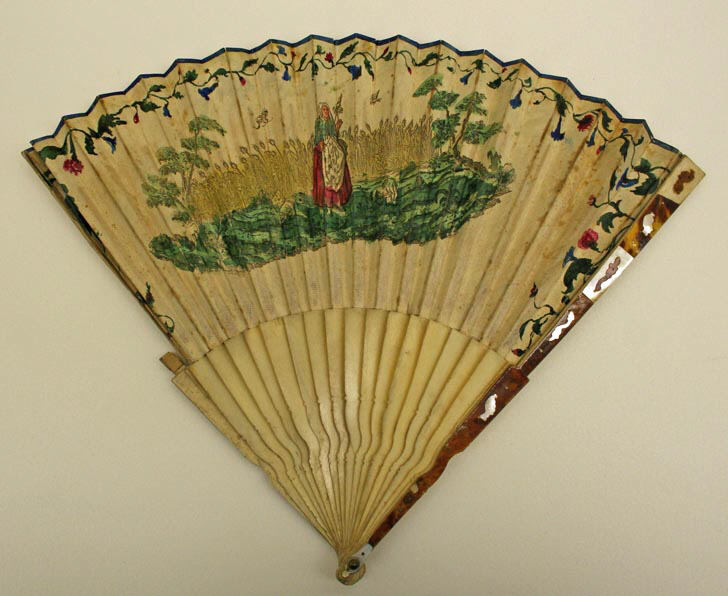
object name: fan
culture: european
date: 1701-1800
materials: bone, paper, shell